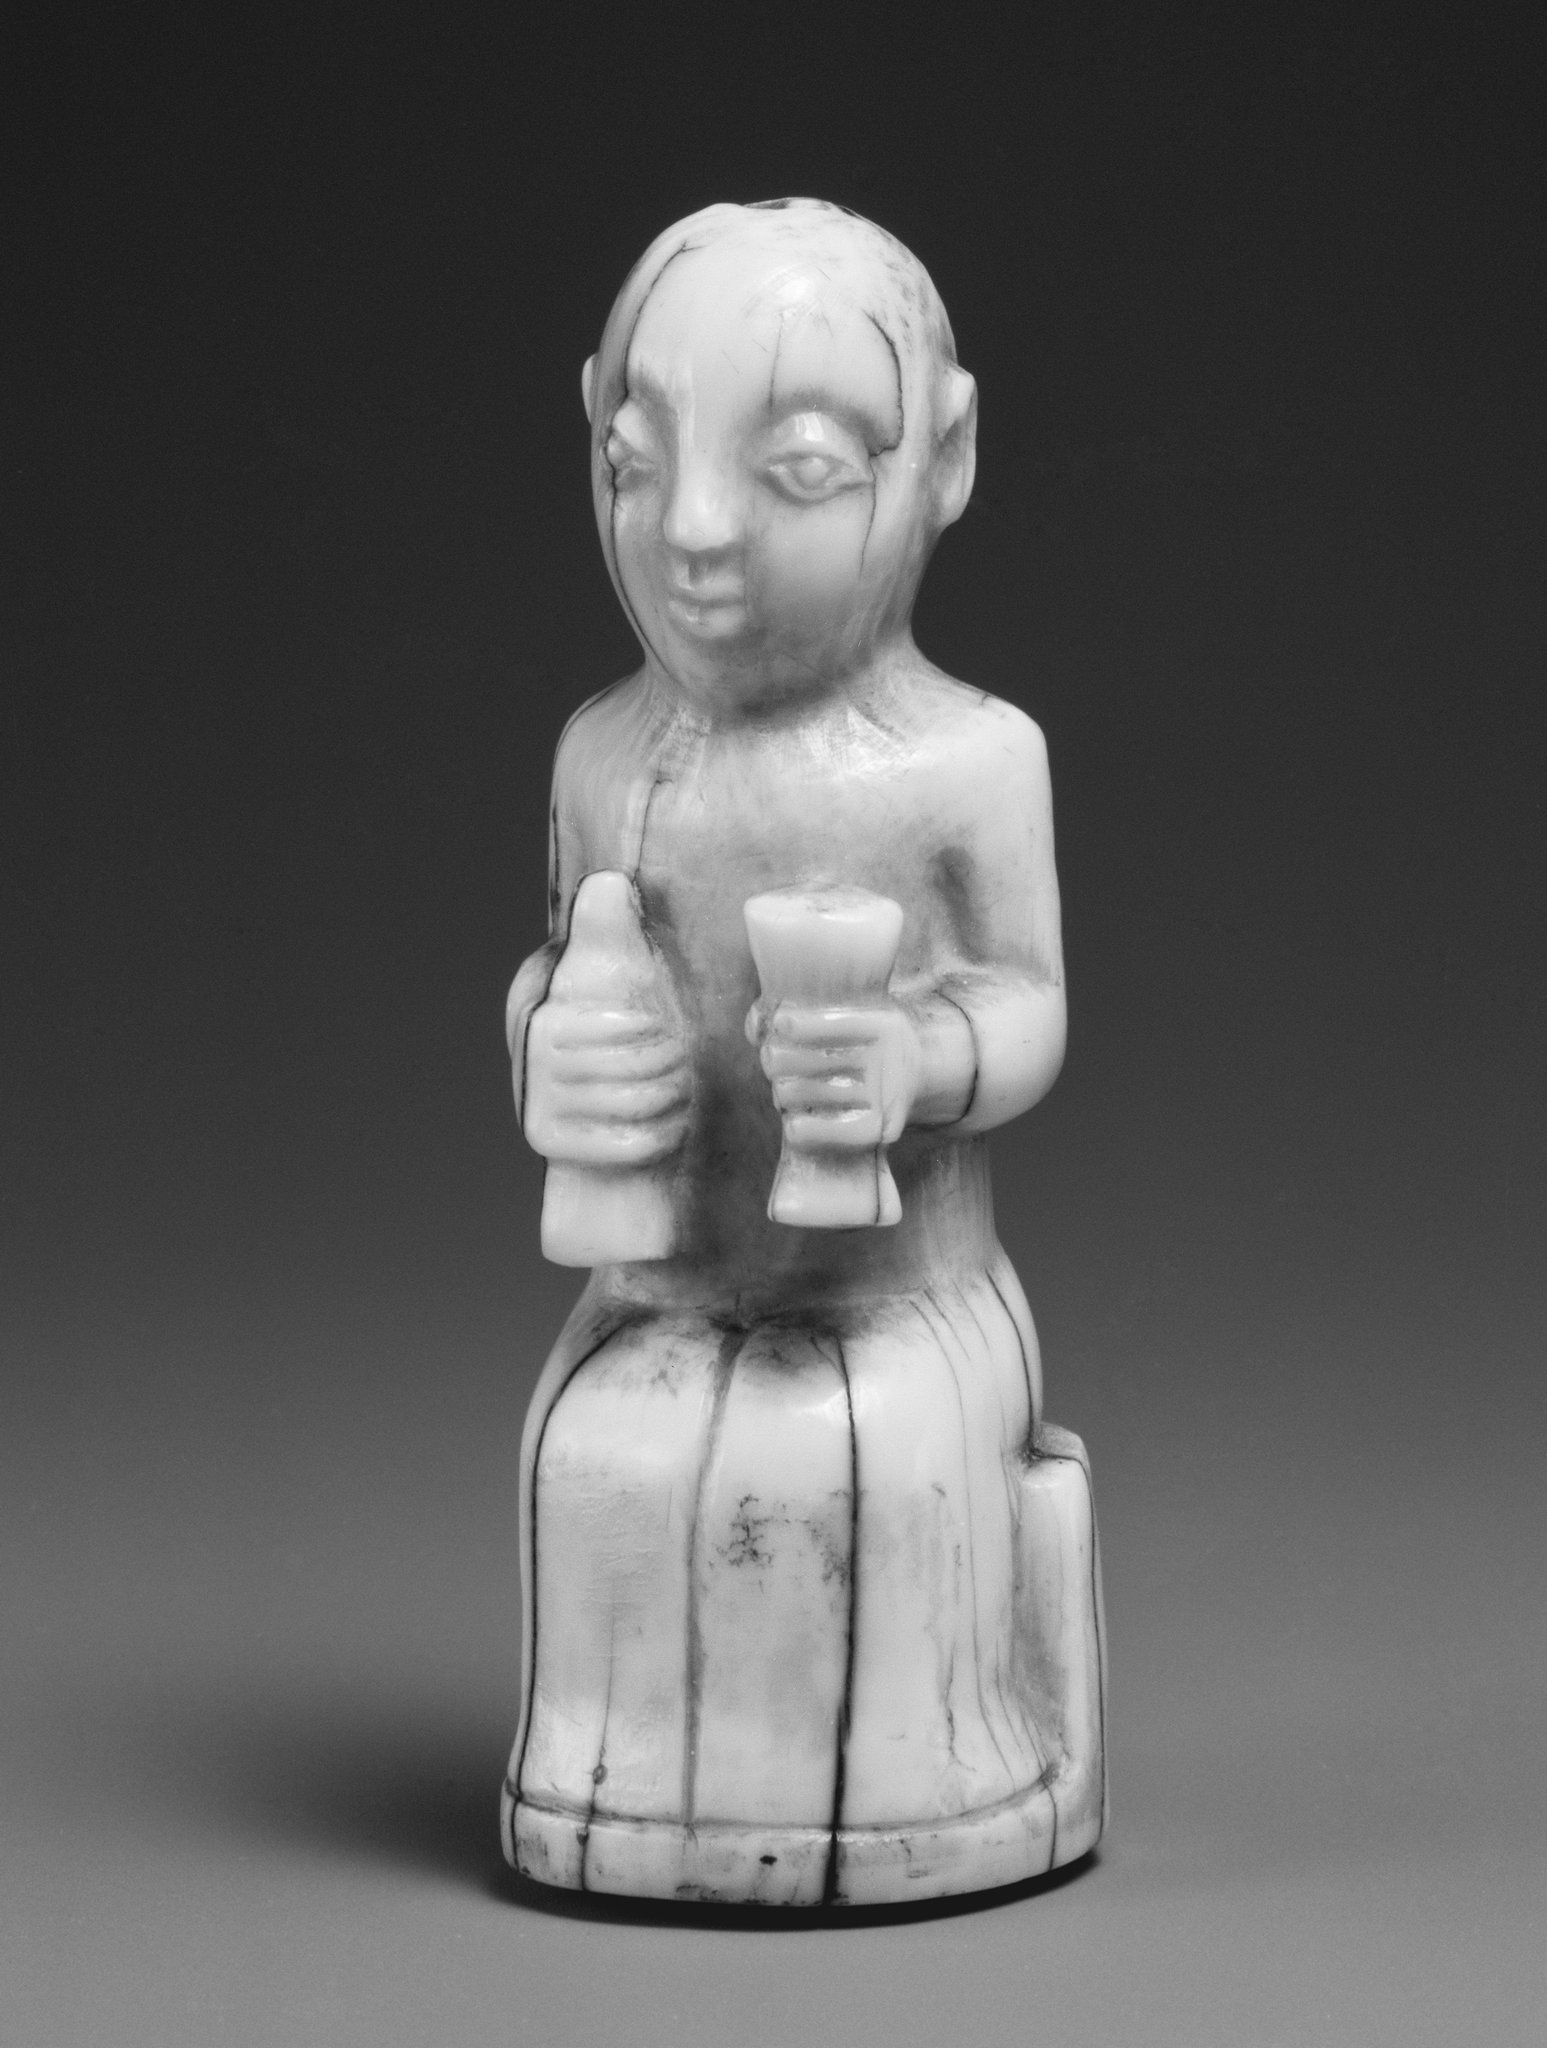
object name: male figure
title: Figure: Seated Male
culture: kongo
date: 1801-1900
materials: ivory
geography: democratic republic of the congo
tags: men